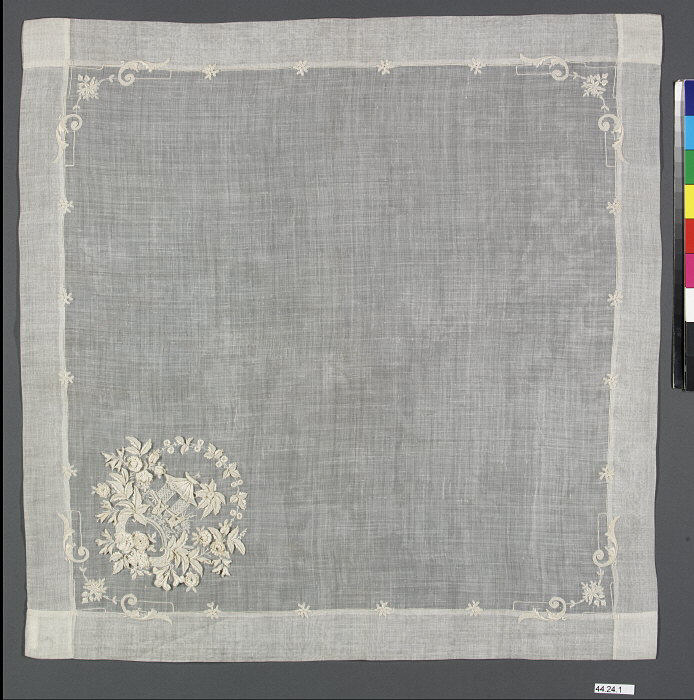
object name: handkerchief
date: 1801-1900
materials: linen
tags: flowers